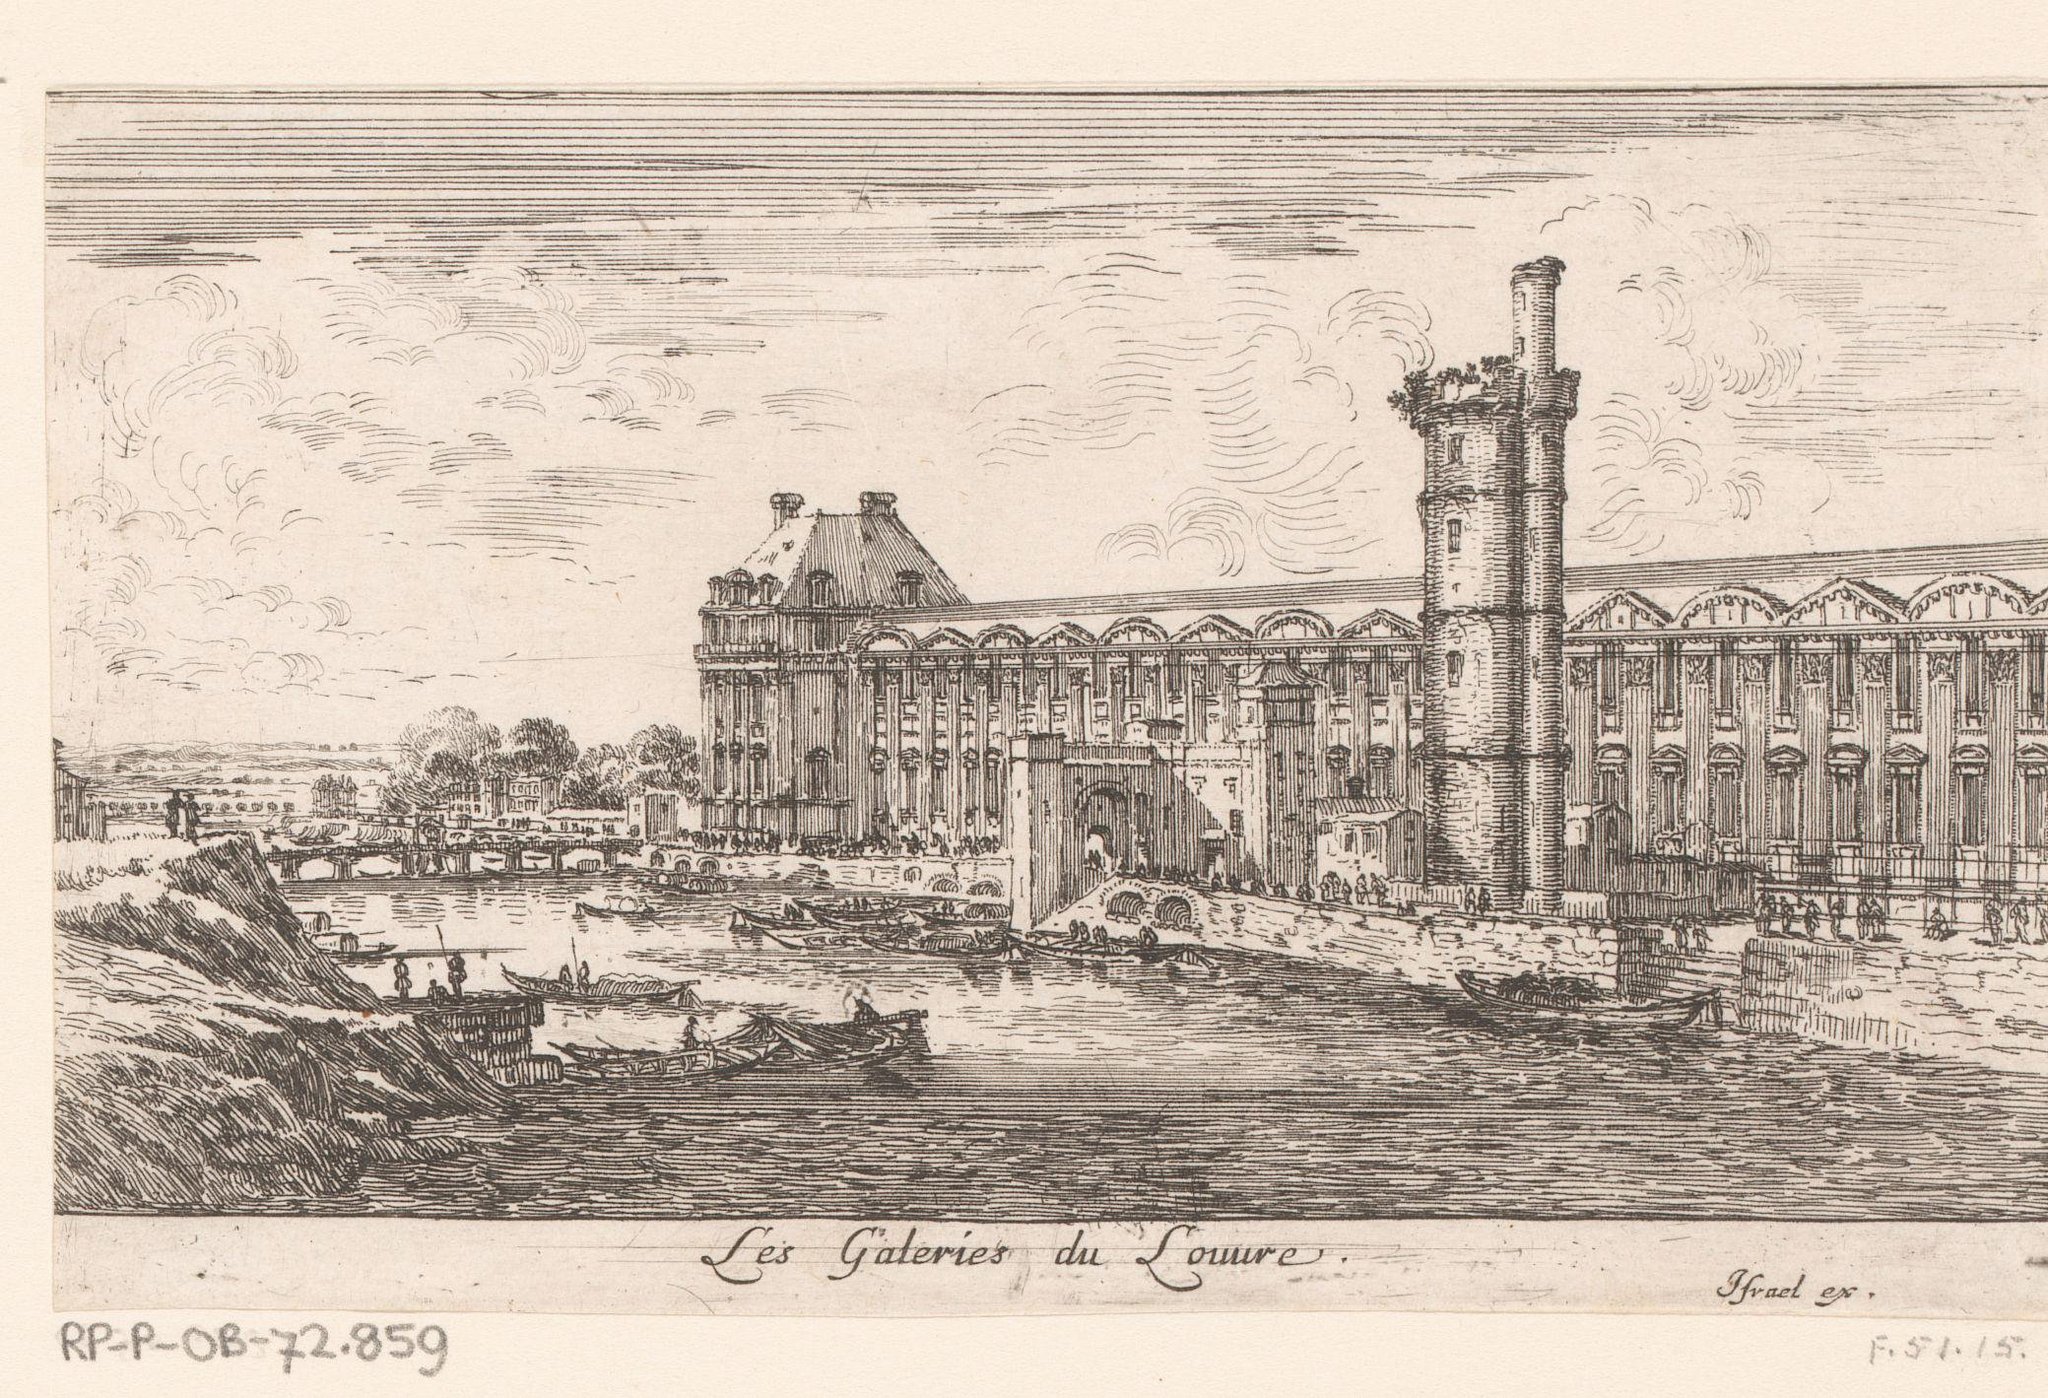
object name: print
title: Les Galeries du Louvre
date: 1652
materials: paper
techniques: etching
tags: landscape with tower or castle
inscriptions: collector's mark: Lugt 240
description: Prent maakt deel uit van een ongenummerde serie van twintig prenten.